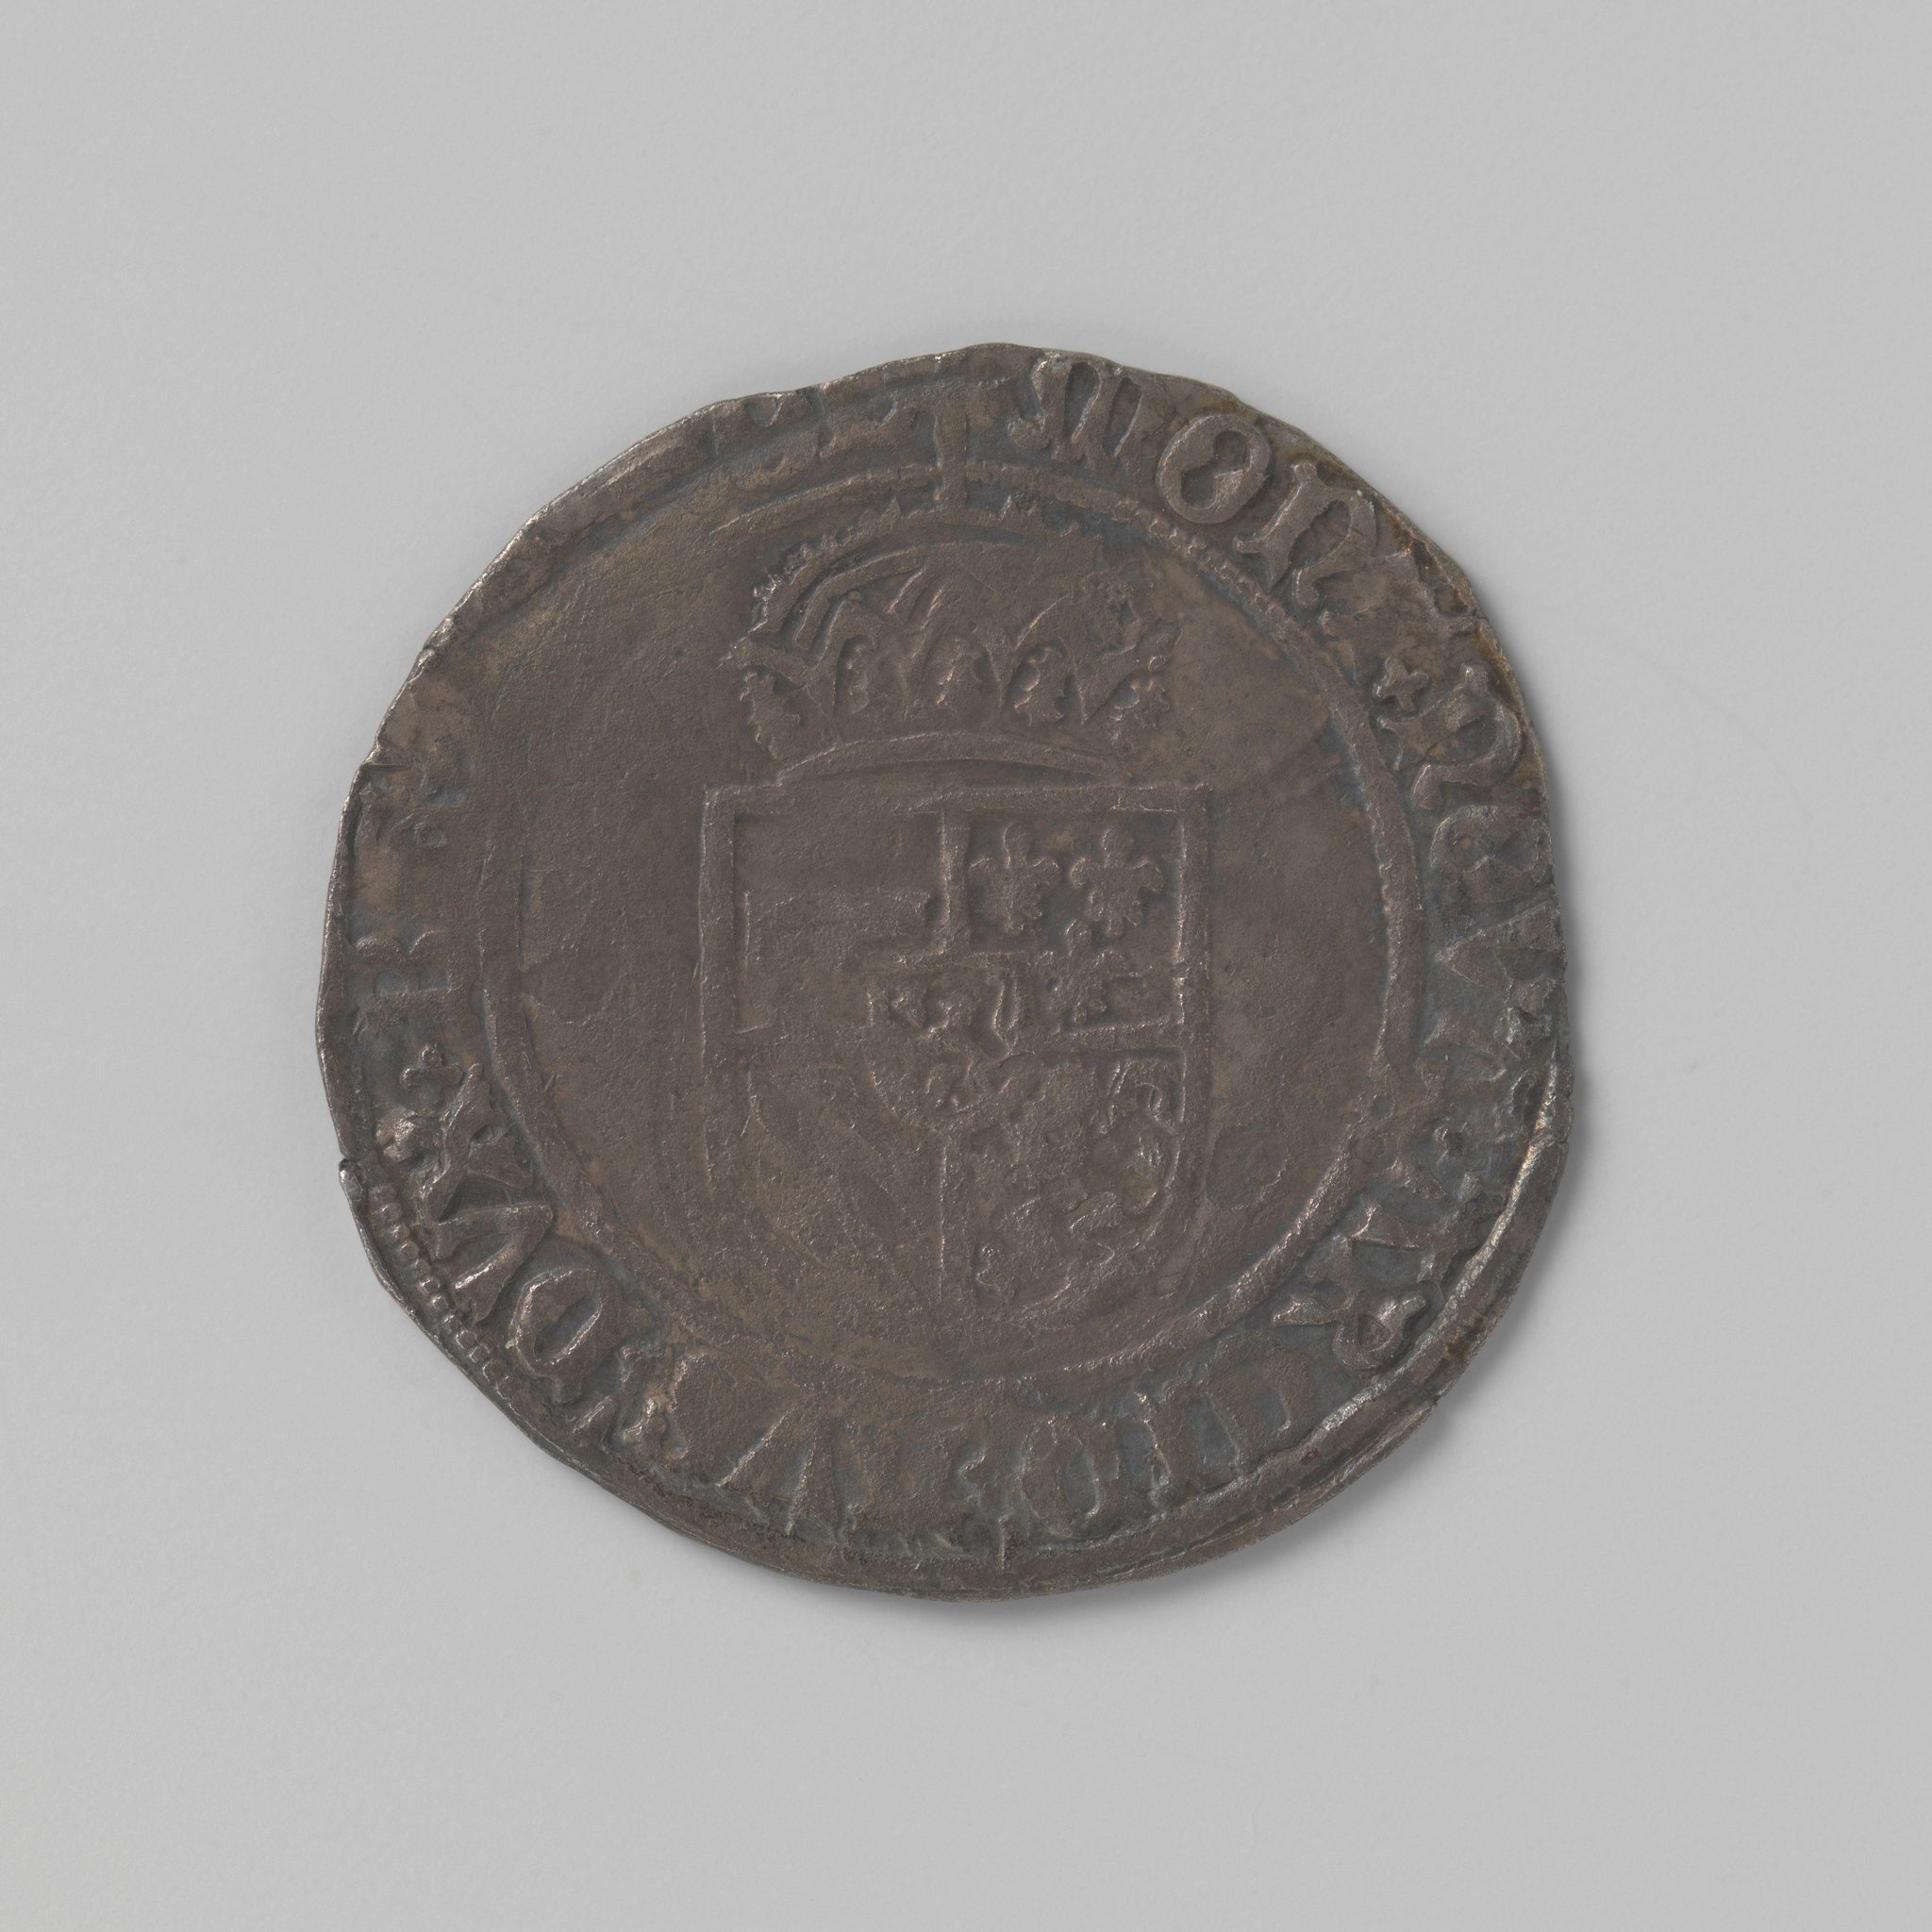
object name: coin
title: Holland, Karel V, stuiver, 1499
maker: charles v (holy roman emperor and king of spain)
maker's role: keizer, koning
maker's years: 1500-1558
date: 1506-1520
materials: silver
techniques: striking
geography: dordrecht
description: Zilveren munt. Voorzijde: gekroond wapenschild van Oostenrijk-Bourgondië. Keerzijde: op een vierpas lang versierd kruis, in hart roos.